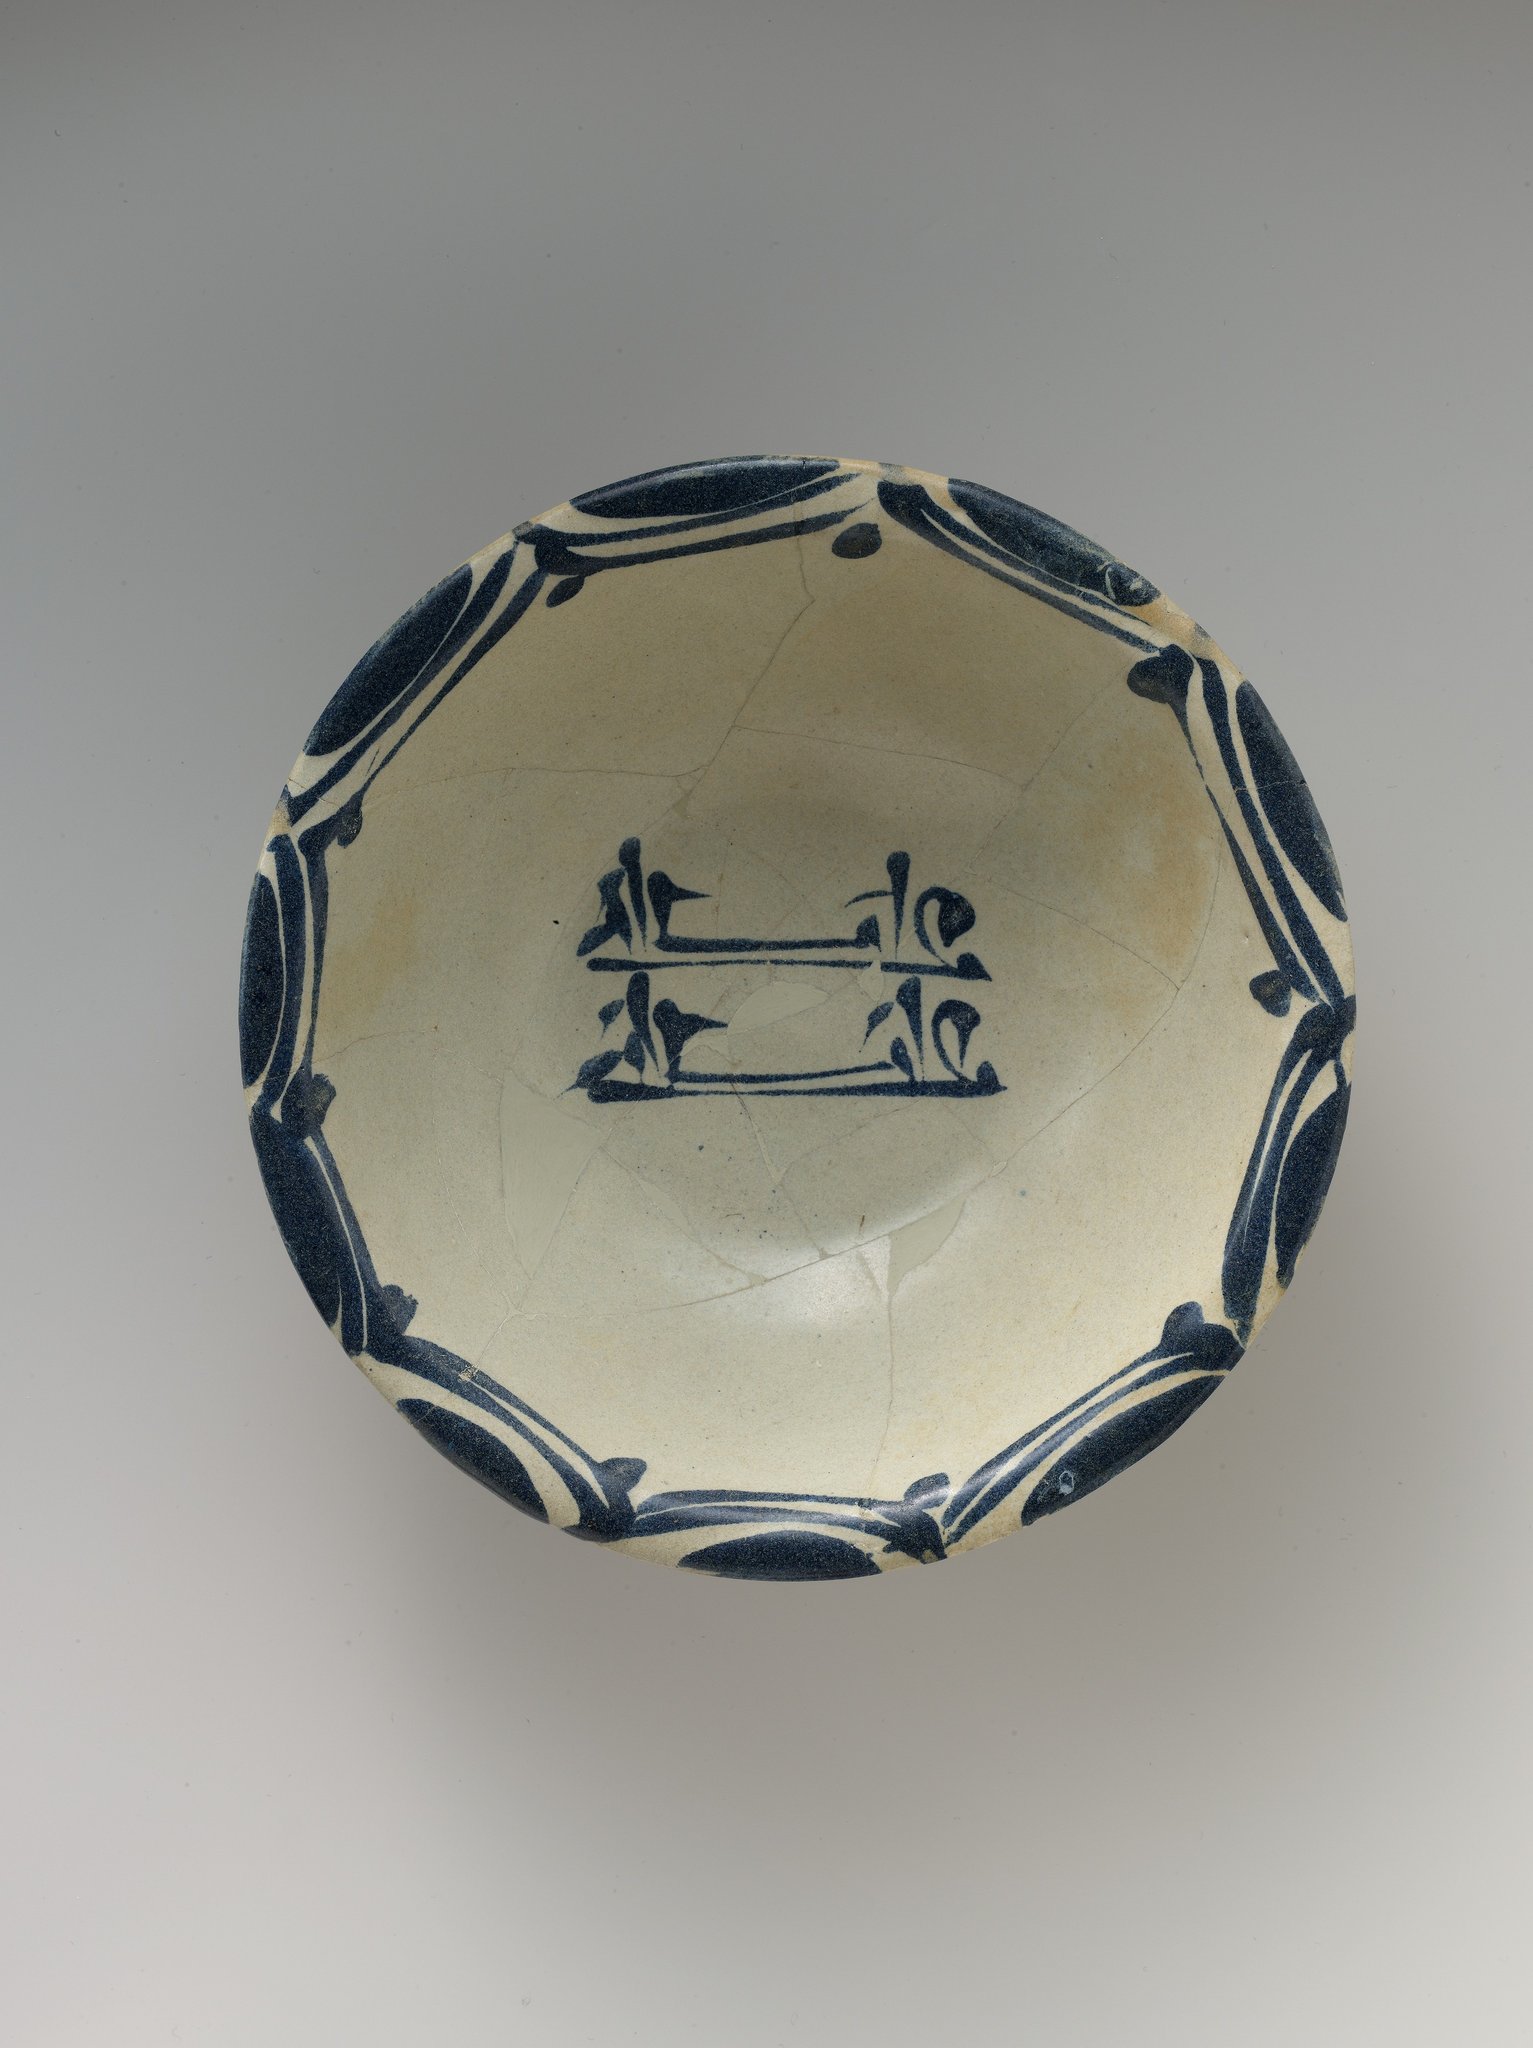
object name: bowl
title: Bowl Emulating Chinese Stoneware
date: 801-900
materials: earthenware, glaze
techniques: painting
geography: iraq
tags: arabic